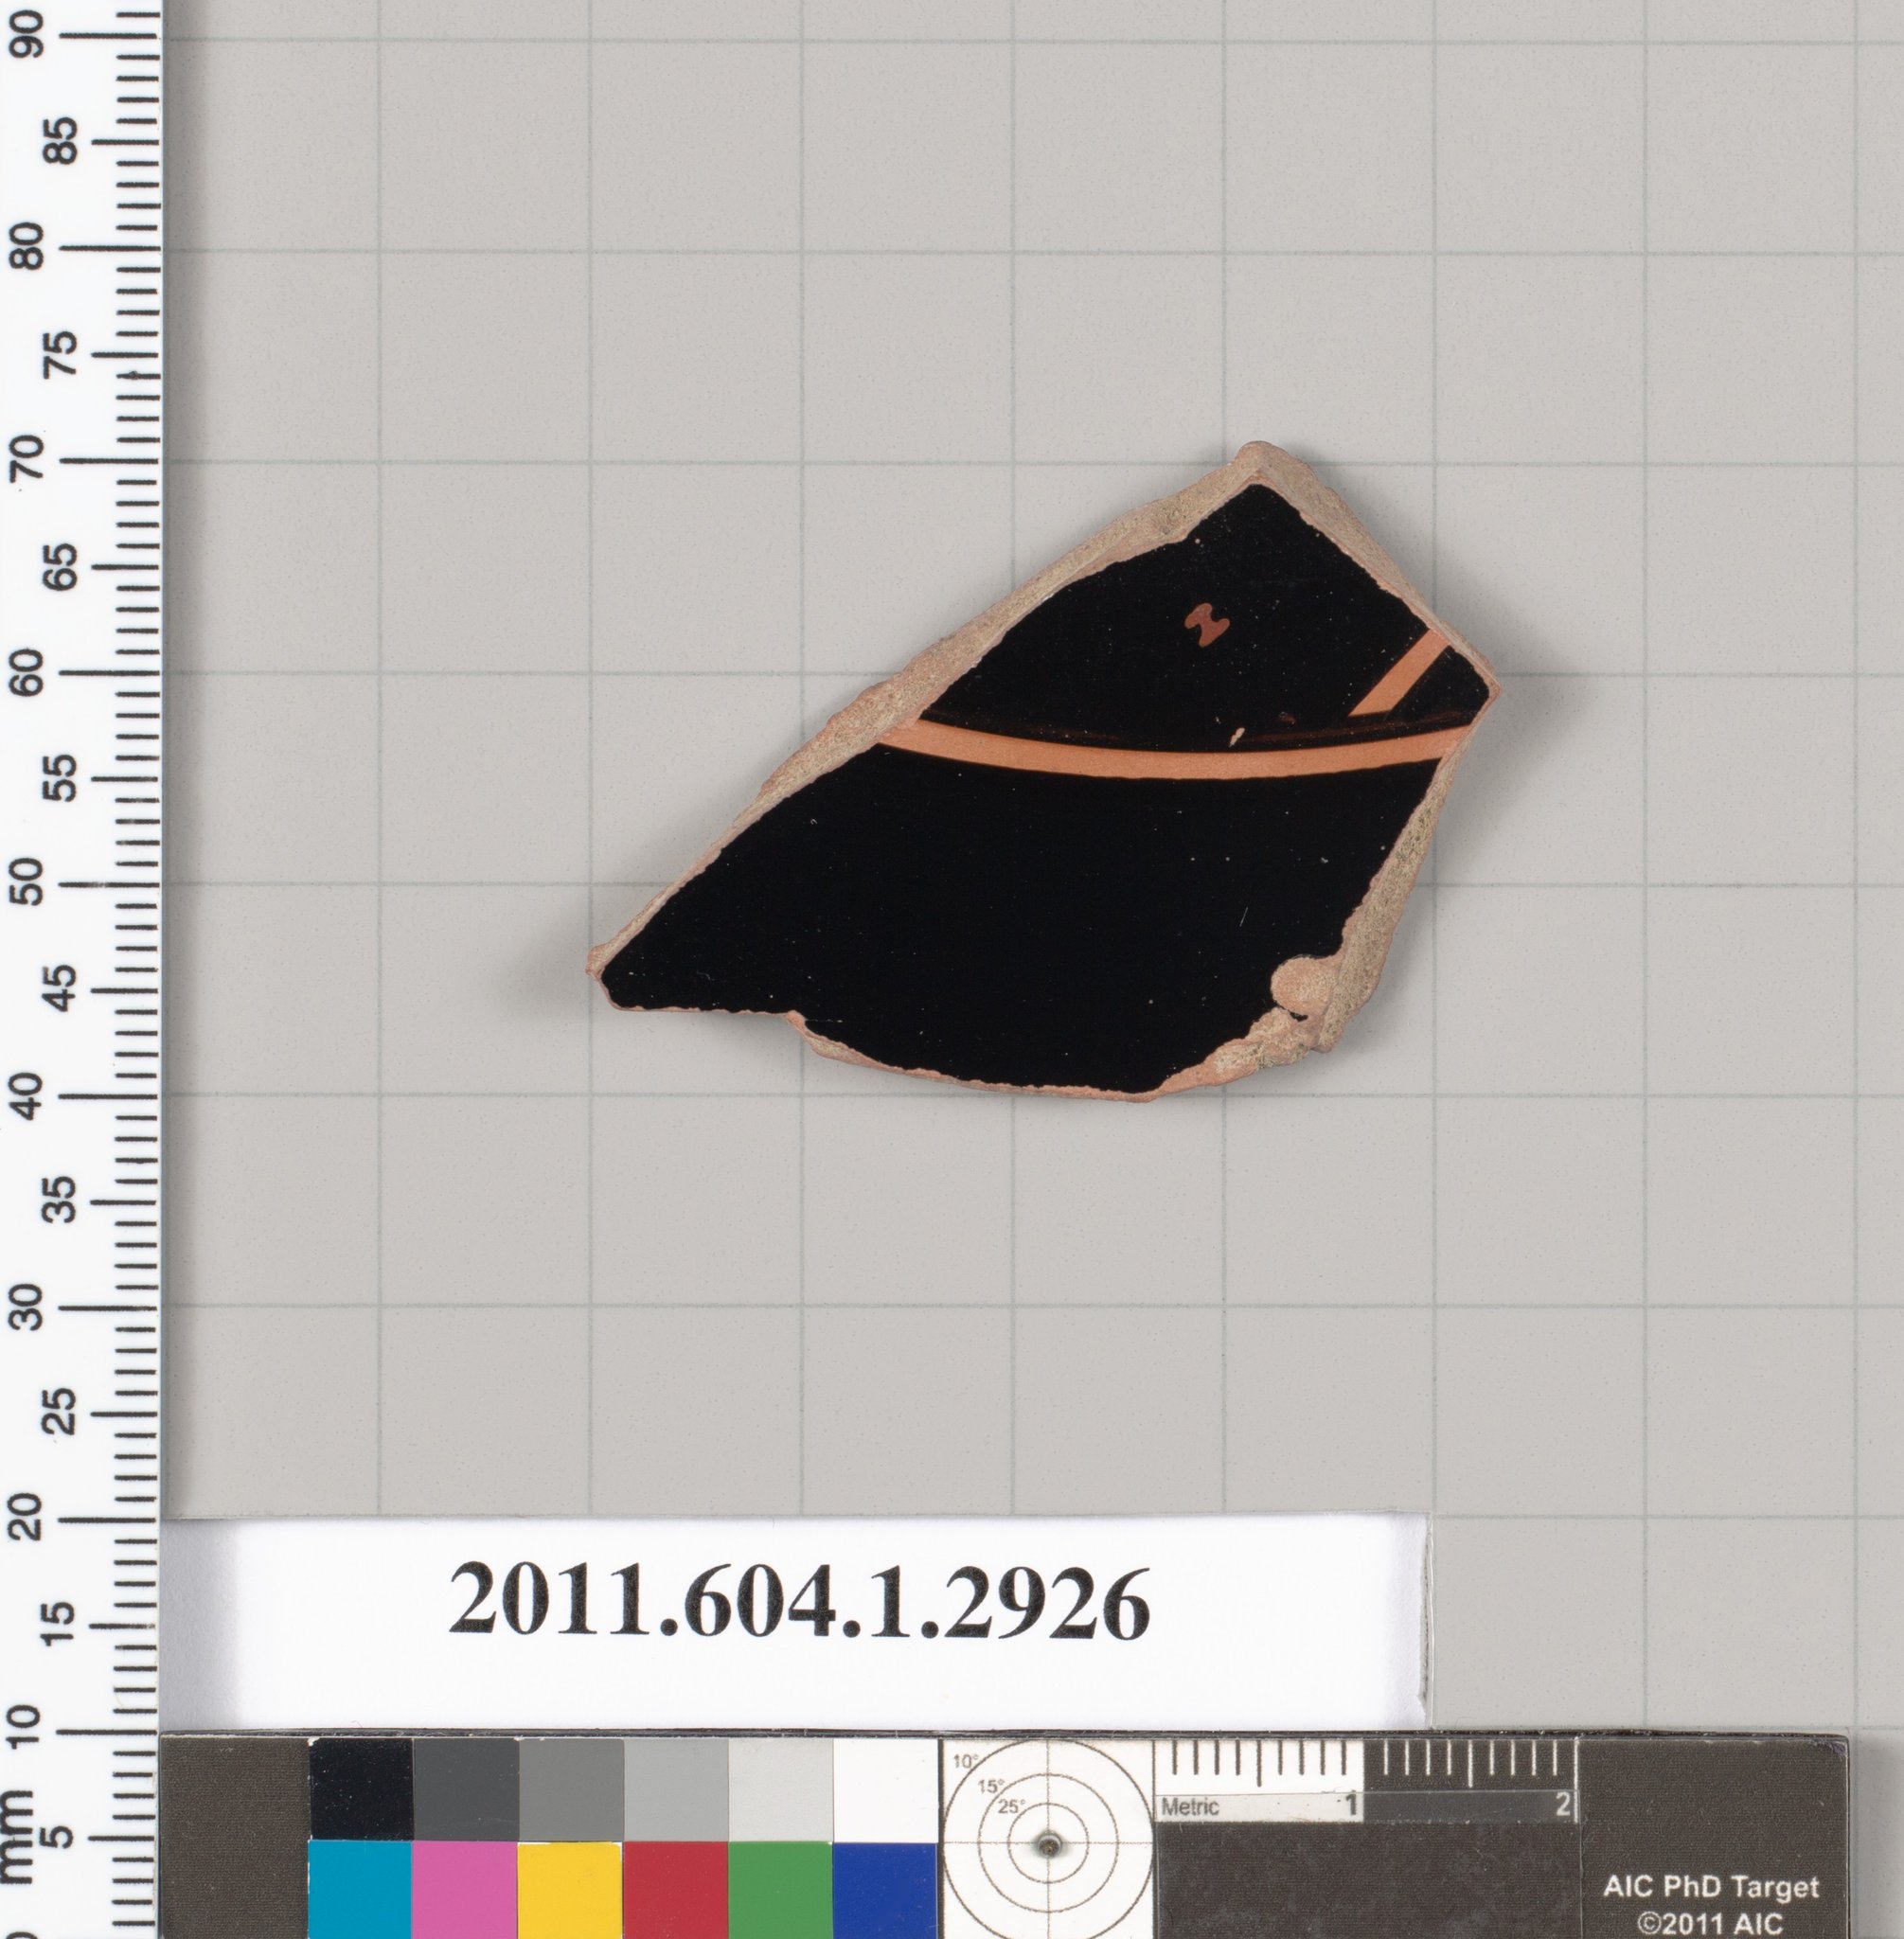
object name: kylix fragment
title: Terracotta fragment of a kylix (drinking cup)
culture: greek, attic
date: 600-401 BCE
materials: terracotta